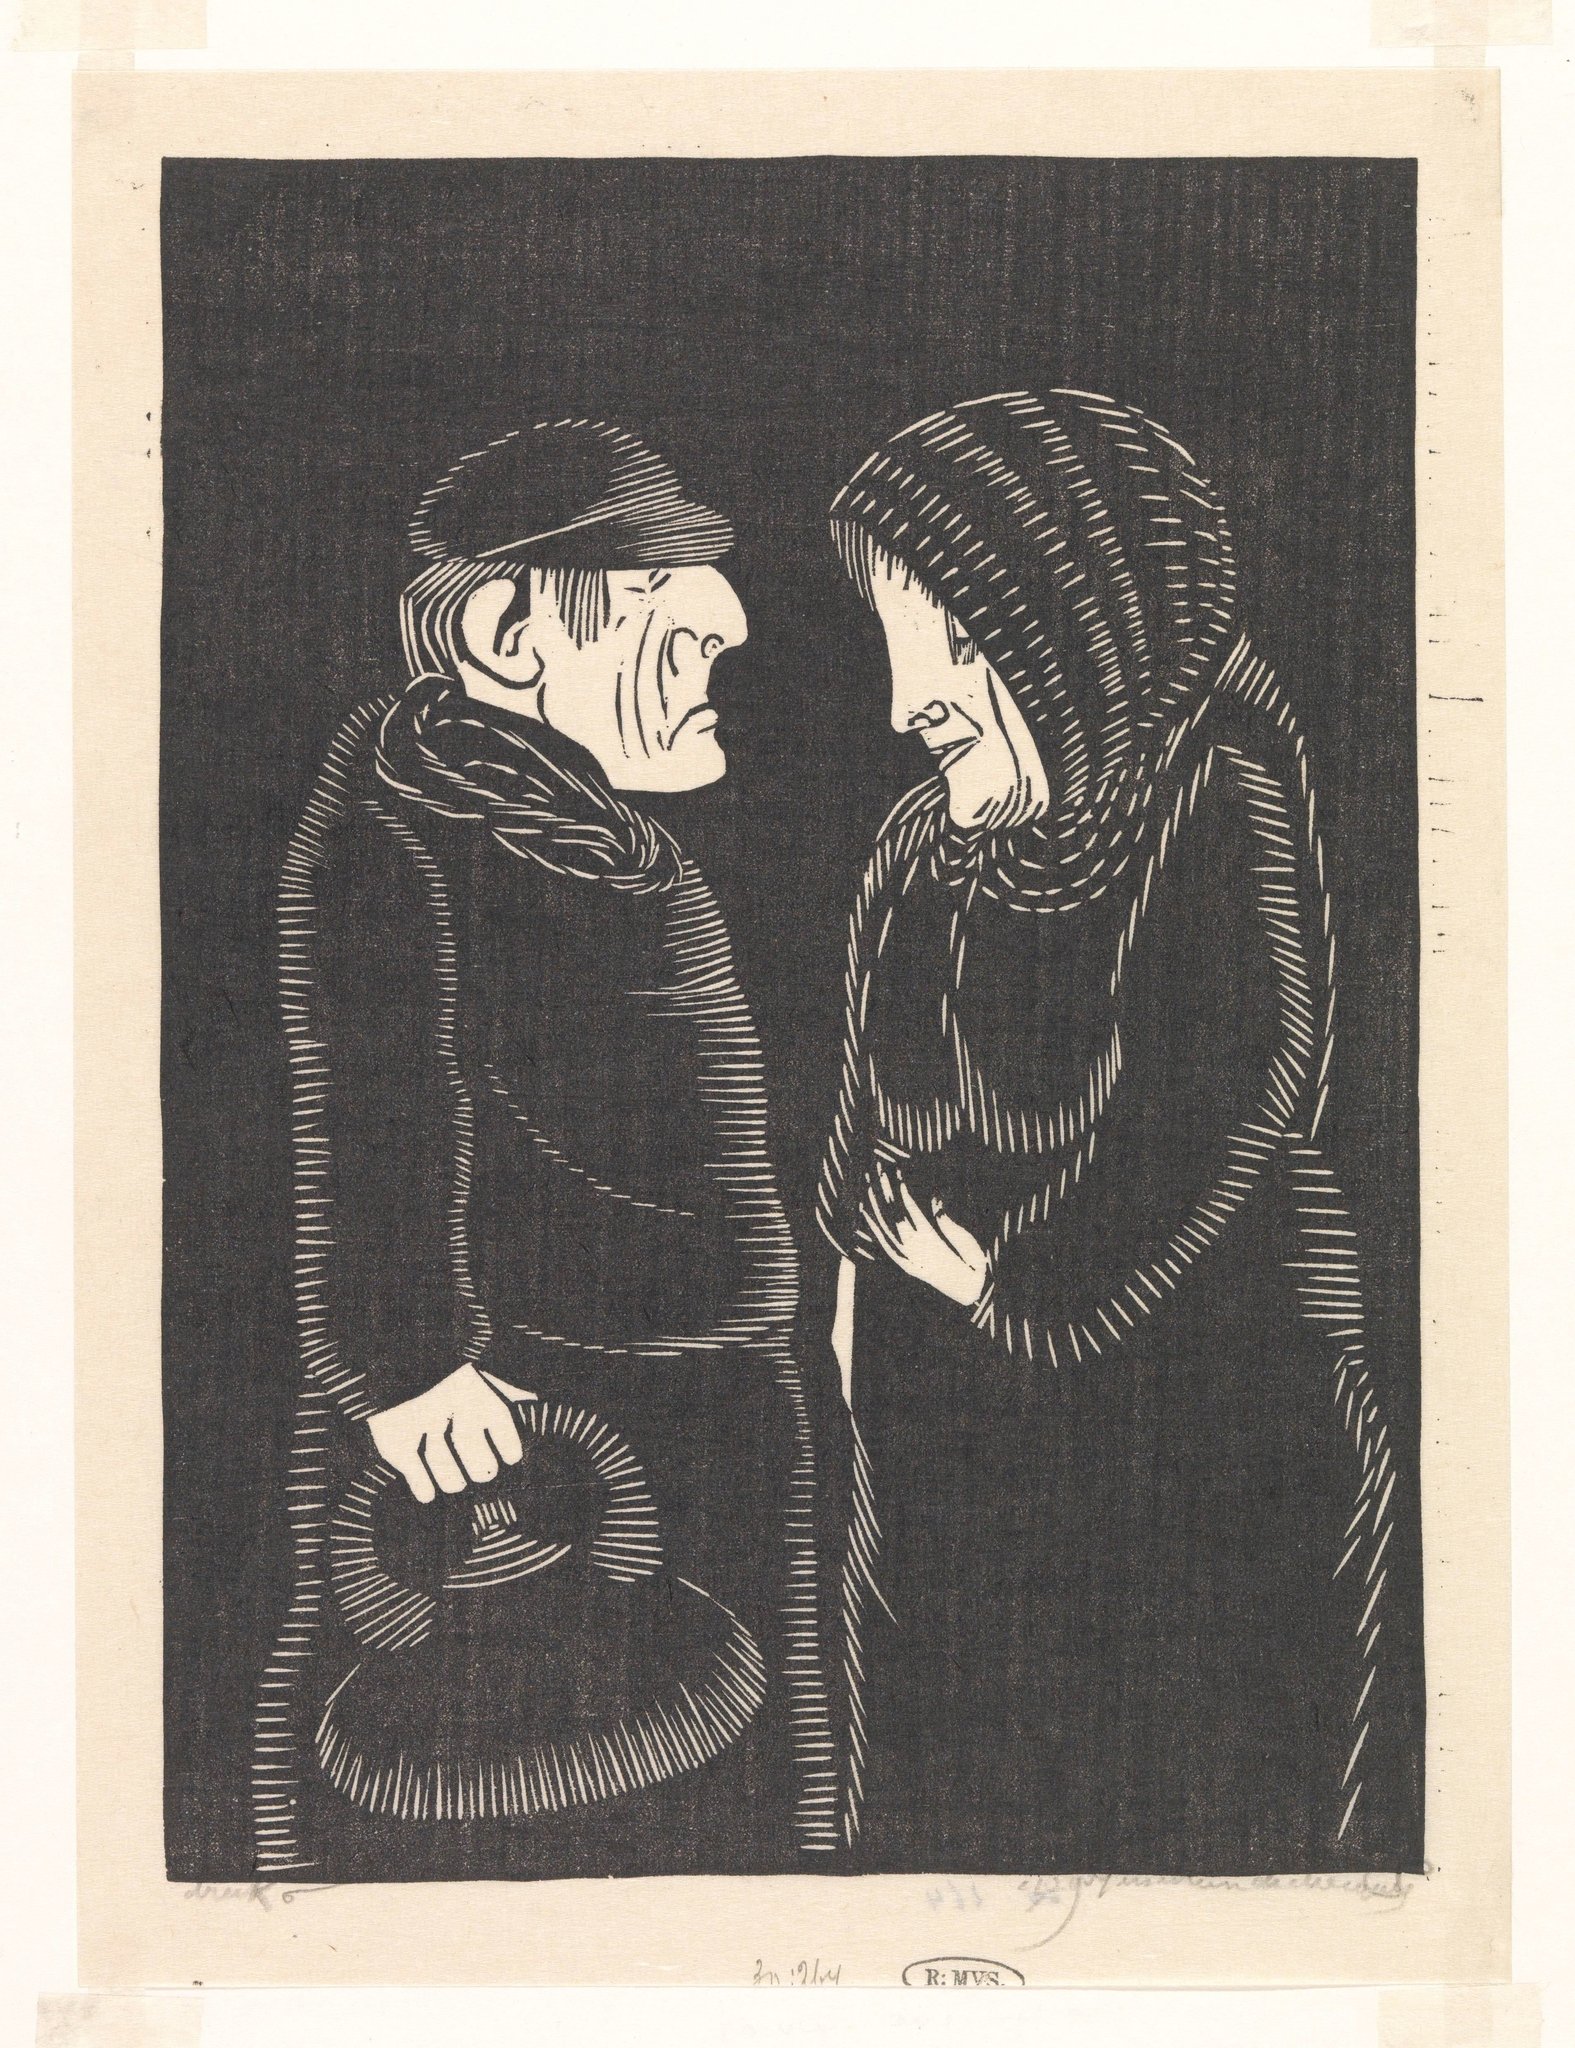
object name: print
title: Fantasie: man en vrouw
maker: samuel jessurun de mesquita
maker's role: draughtsman, print maker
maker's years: 1868-1944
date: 1929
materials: paper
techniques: woodcut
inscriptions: edition: ‘druk 6’, signature and date: ‘1929 jessurun de mesquita’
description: Man met pet tegenover vrouw met hoofddoek.